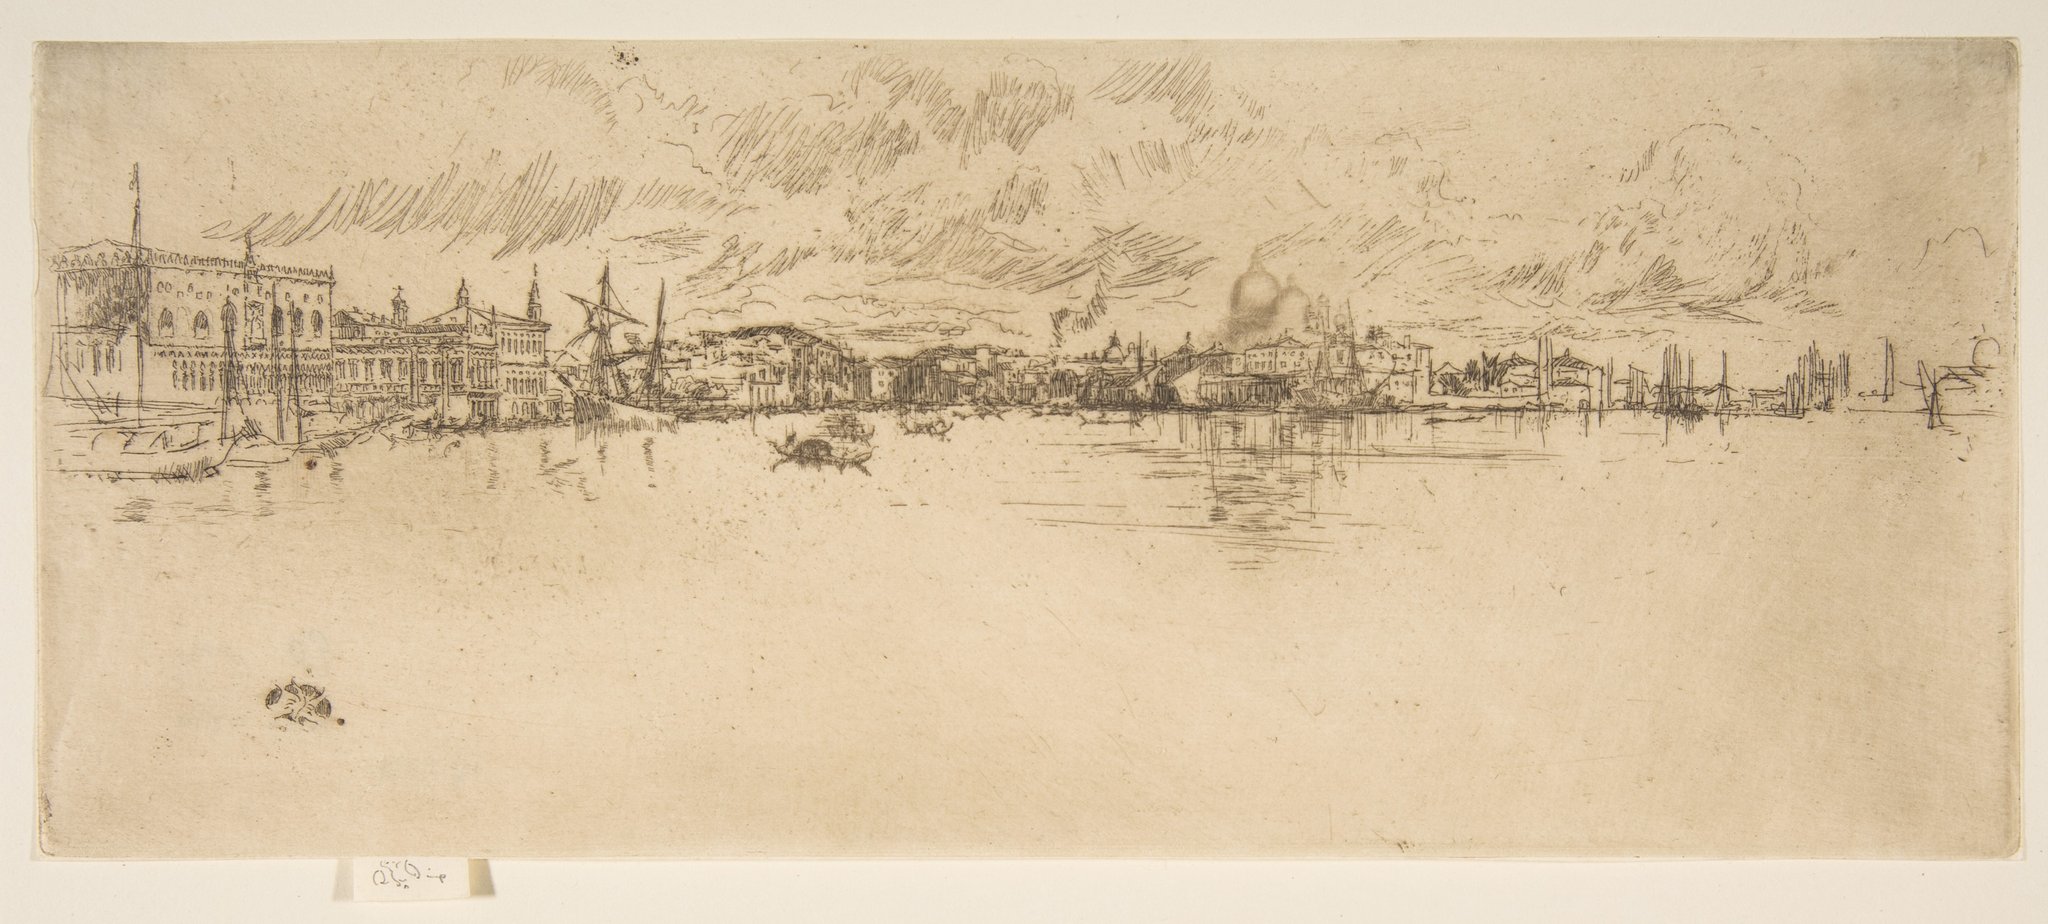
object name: print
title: Long Venice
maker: james mcneill whistler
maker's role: artist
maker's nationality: american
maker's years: 1834-1903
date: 1879-1880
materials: ink, paper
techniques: drypoint, etching, printing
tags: cities,boats,venice